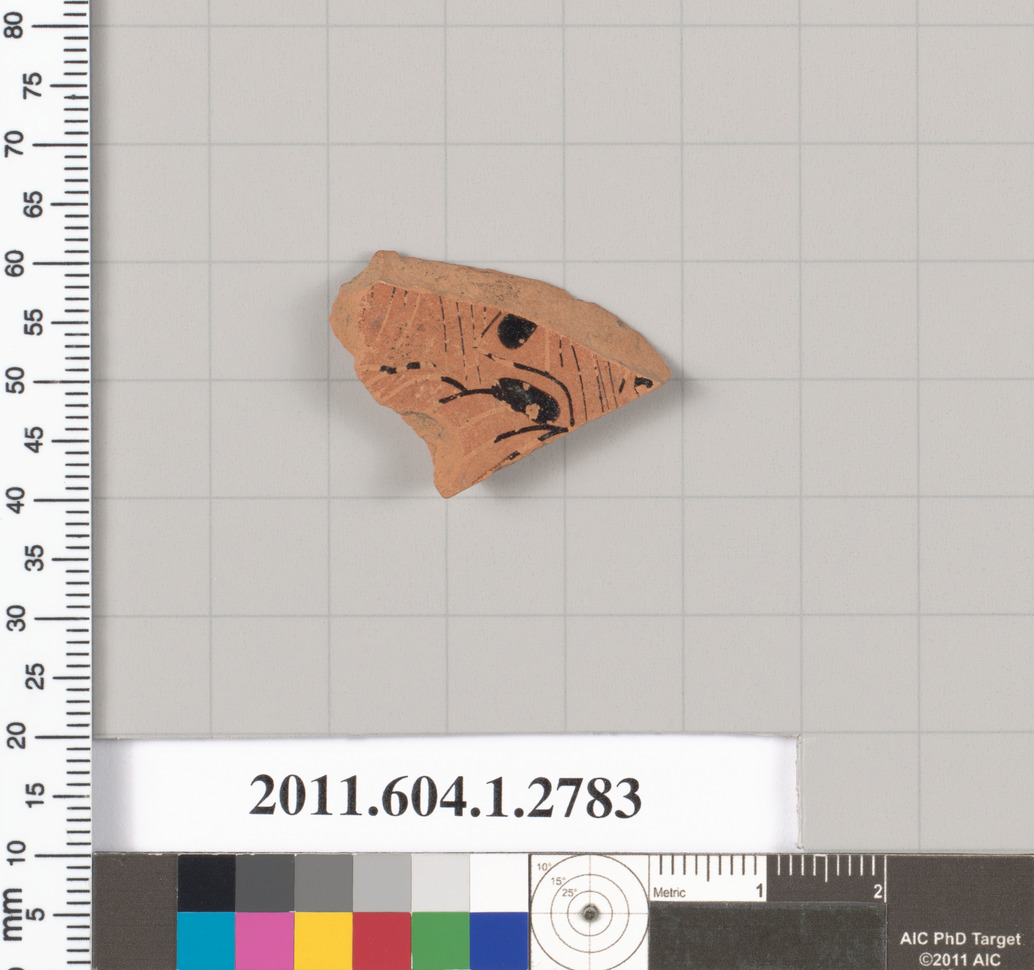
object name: kylix fragment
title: Terracotta fragment of a kylix (drinking cup)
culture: greek, attic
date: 500-476 BCE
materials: terracotta